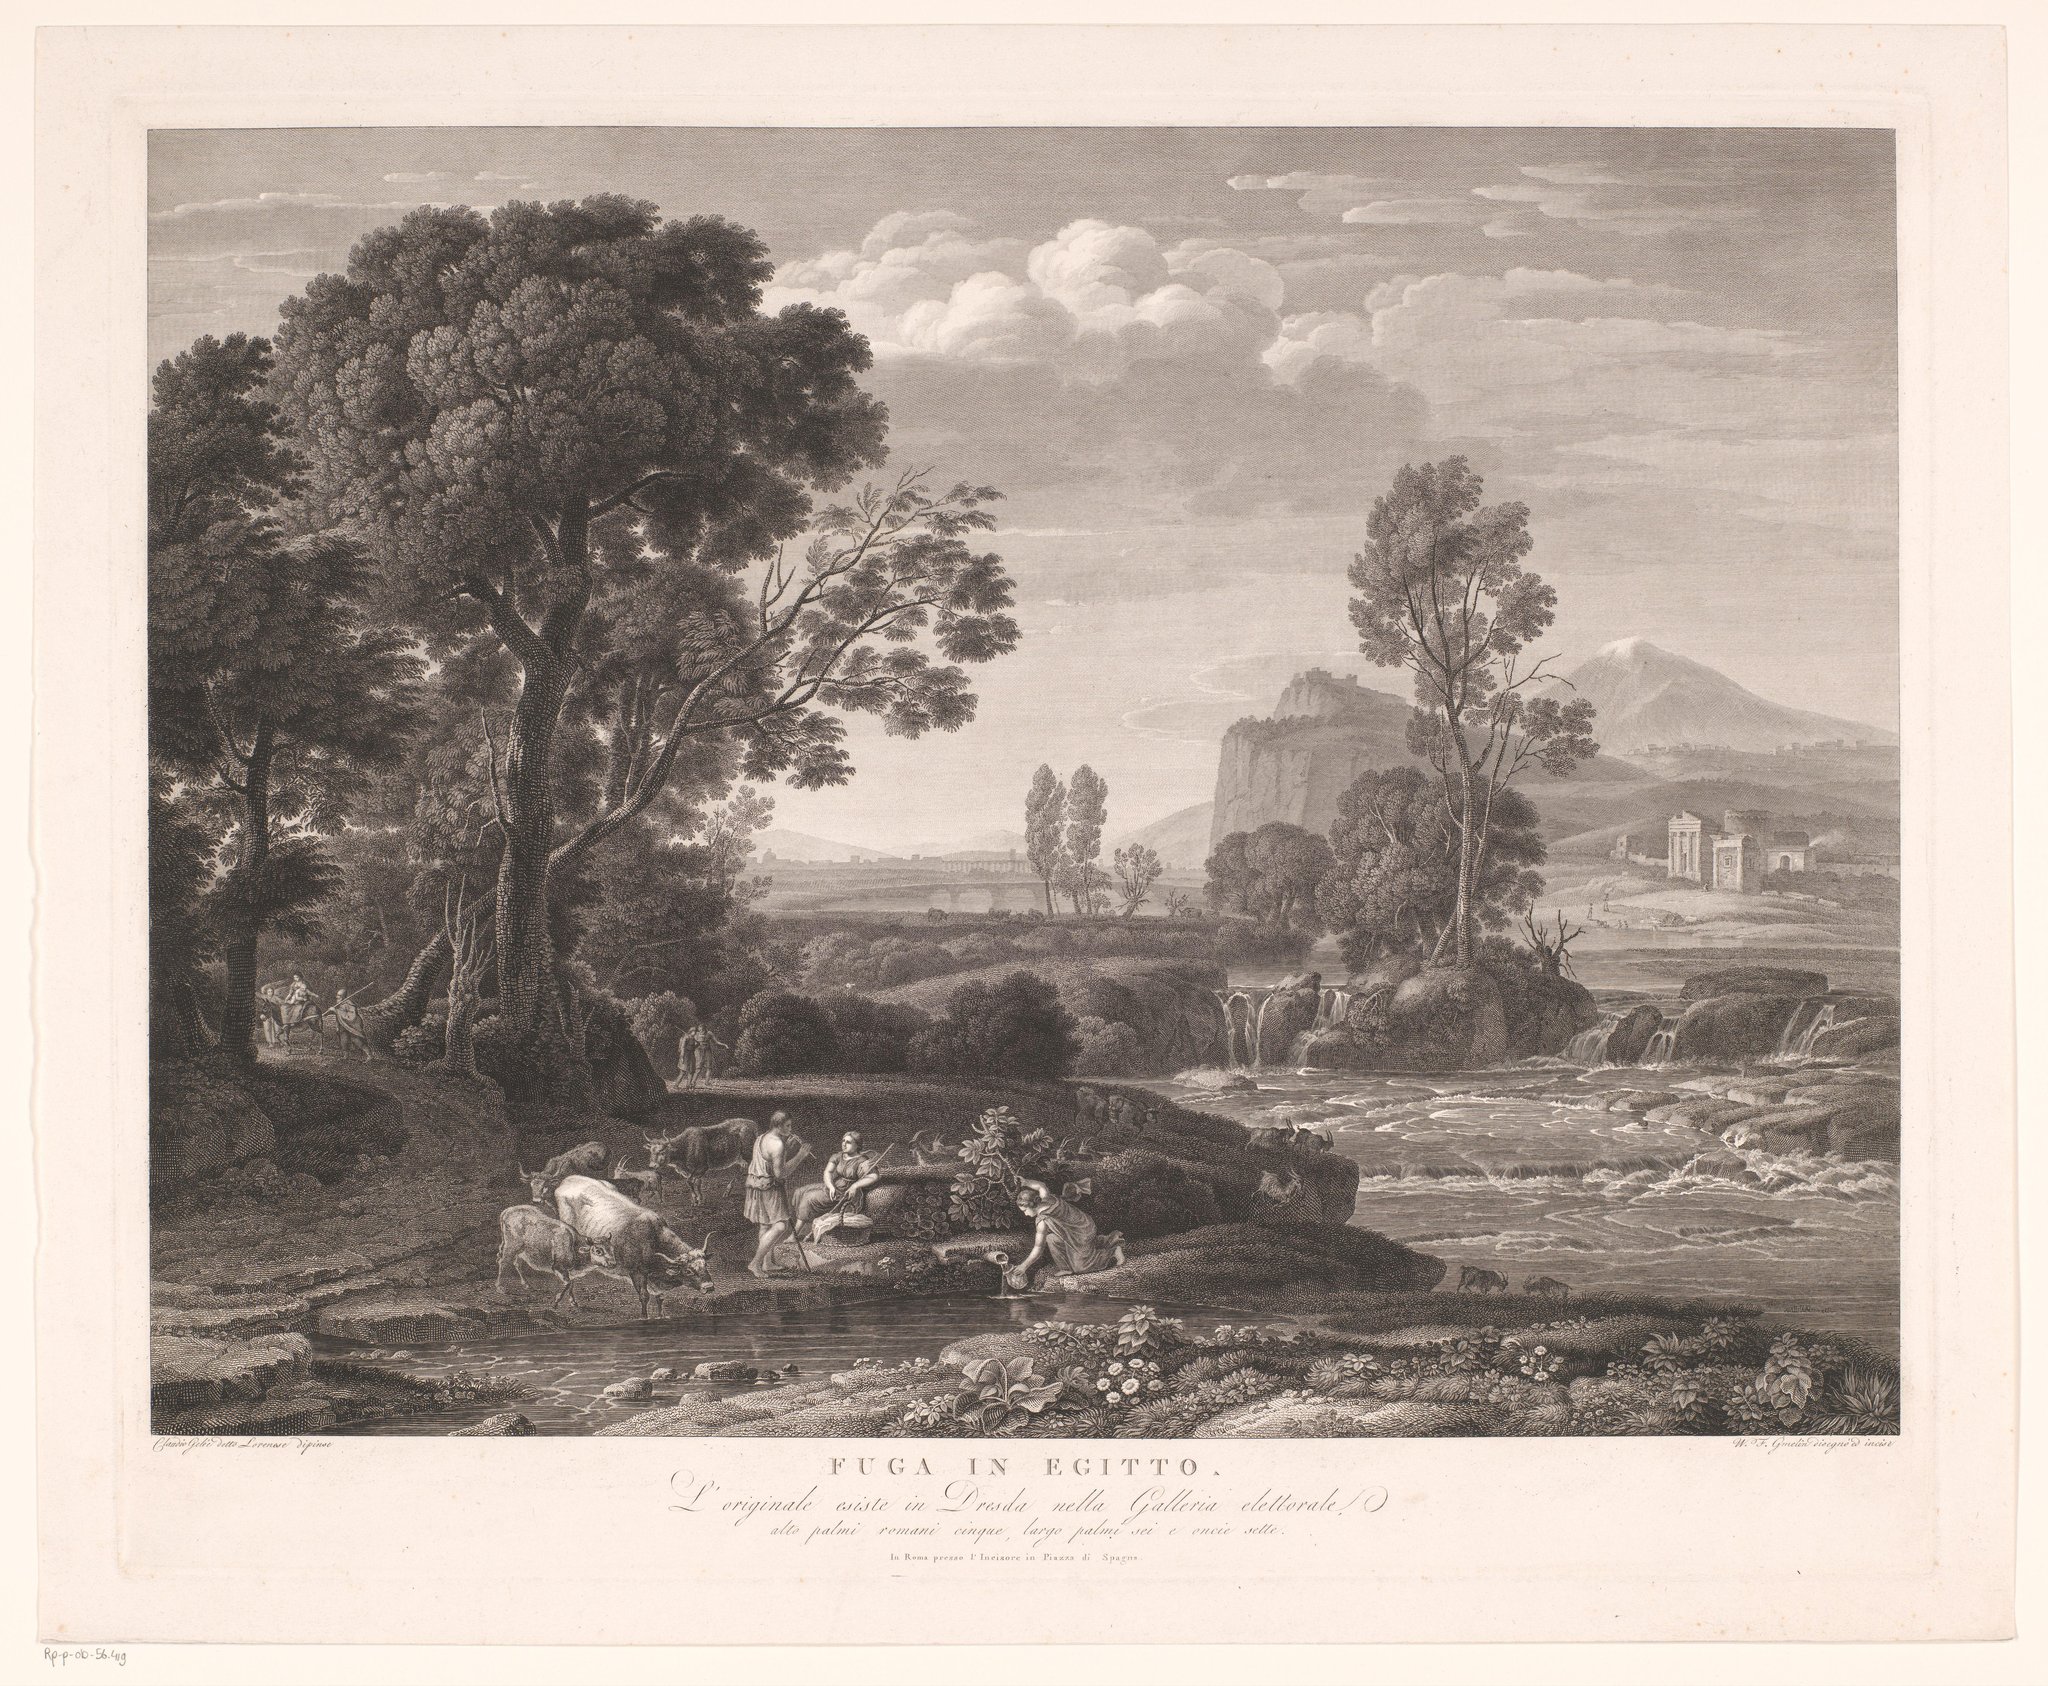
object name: print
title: Landschap met de vlucht naar Egypte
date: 1770-1820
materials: paper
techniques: engraving, etching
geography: rome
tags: the flight into egypt: mary, joseph, the child (and sometimes others) on their way; mary usually riding on an ass, landscapes - hh - ideal landscapes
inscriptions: collector's mark: Lugt 2165, collector's mark: Lugt 12